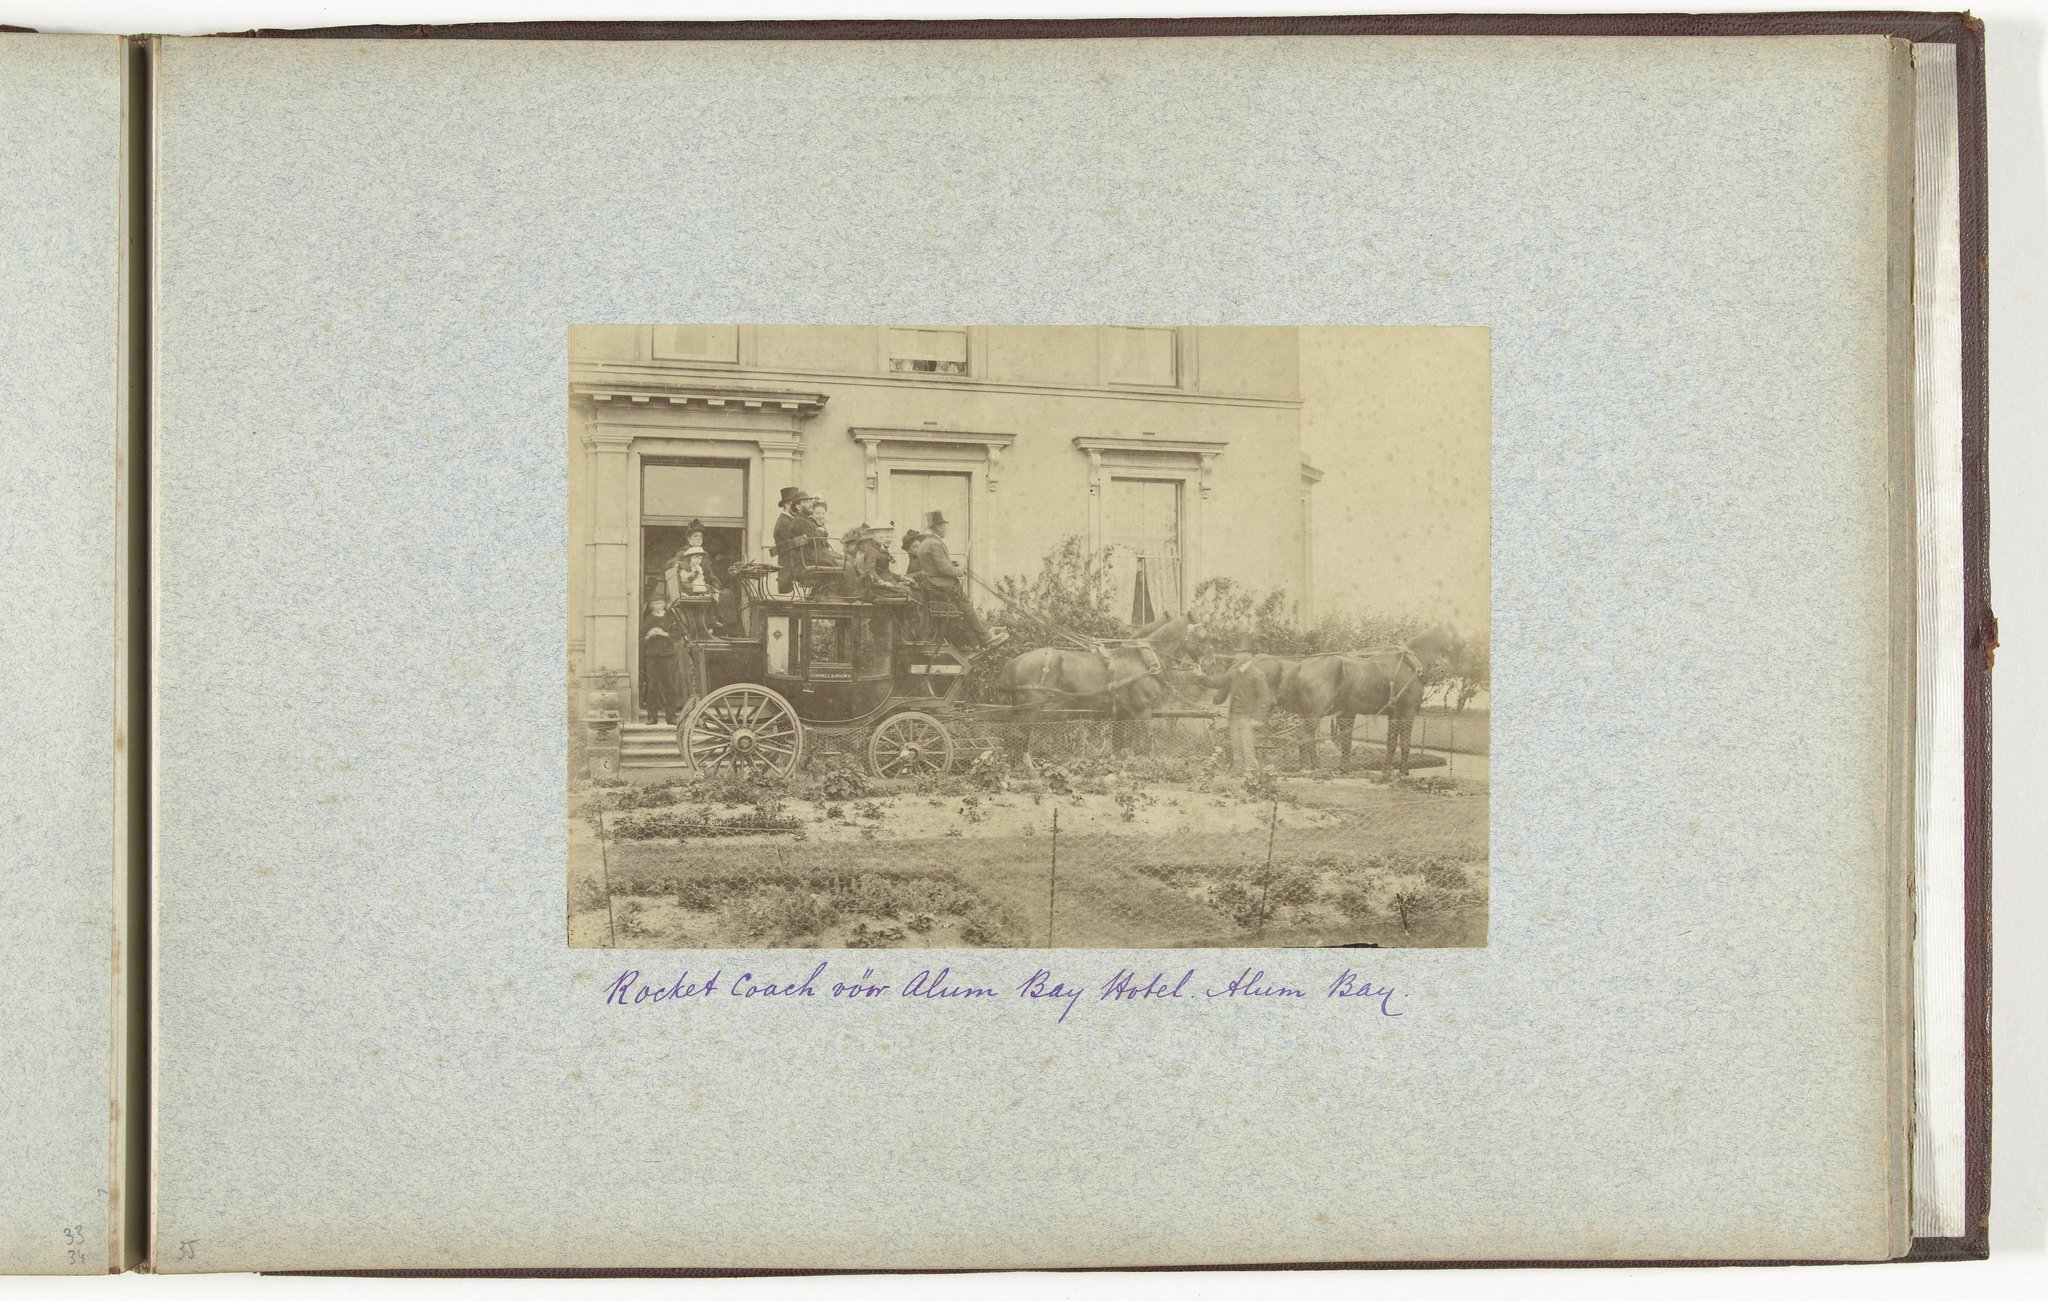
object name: photograph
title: Rijtuig voor het Alum Bay Hotel in Alum Bay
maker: henry pauw van wieldrecht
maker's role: fotograaf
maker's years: 1863-1912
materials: cardboard, paper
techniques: albumen print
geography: alum bay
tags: four-wheeled vehicle drawn by more than three animals